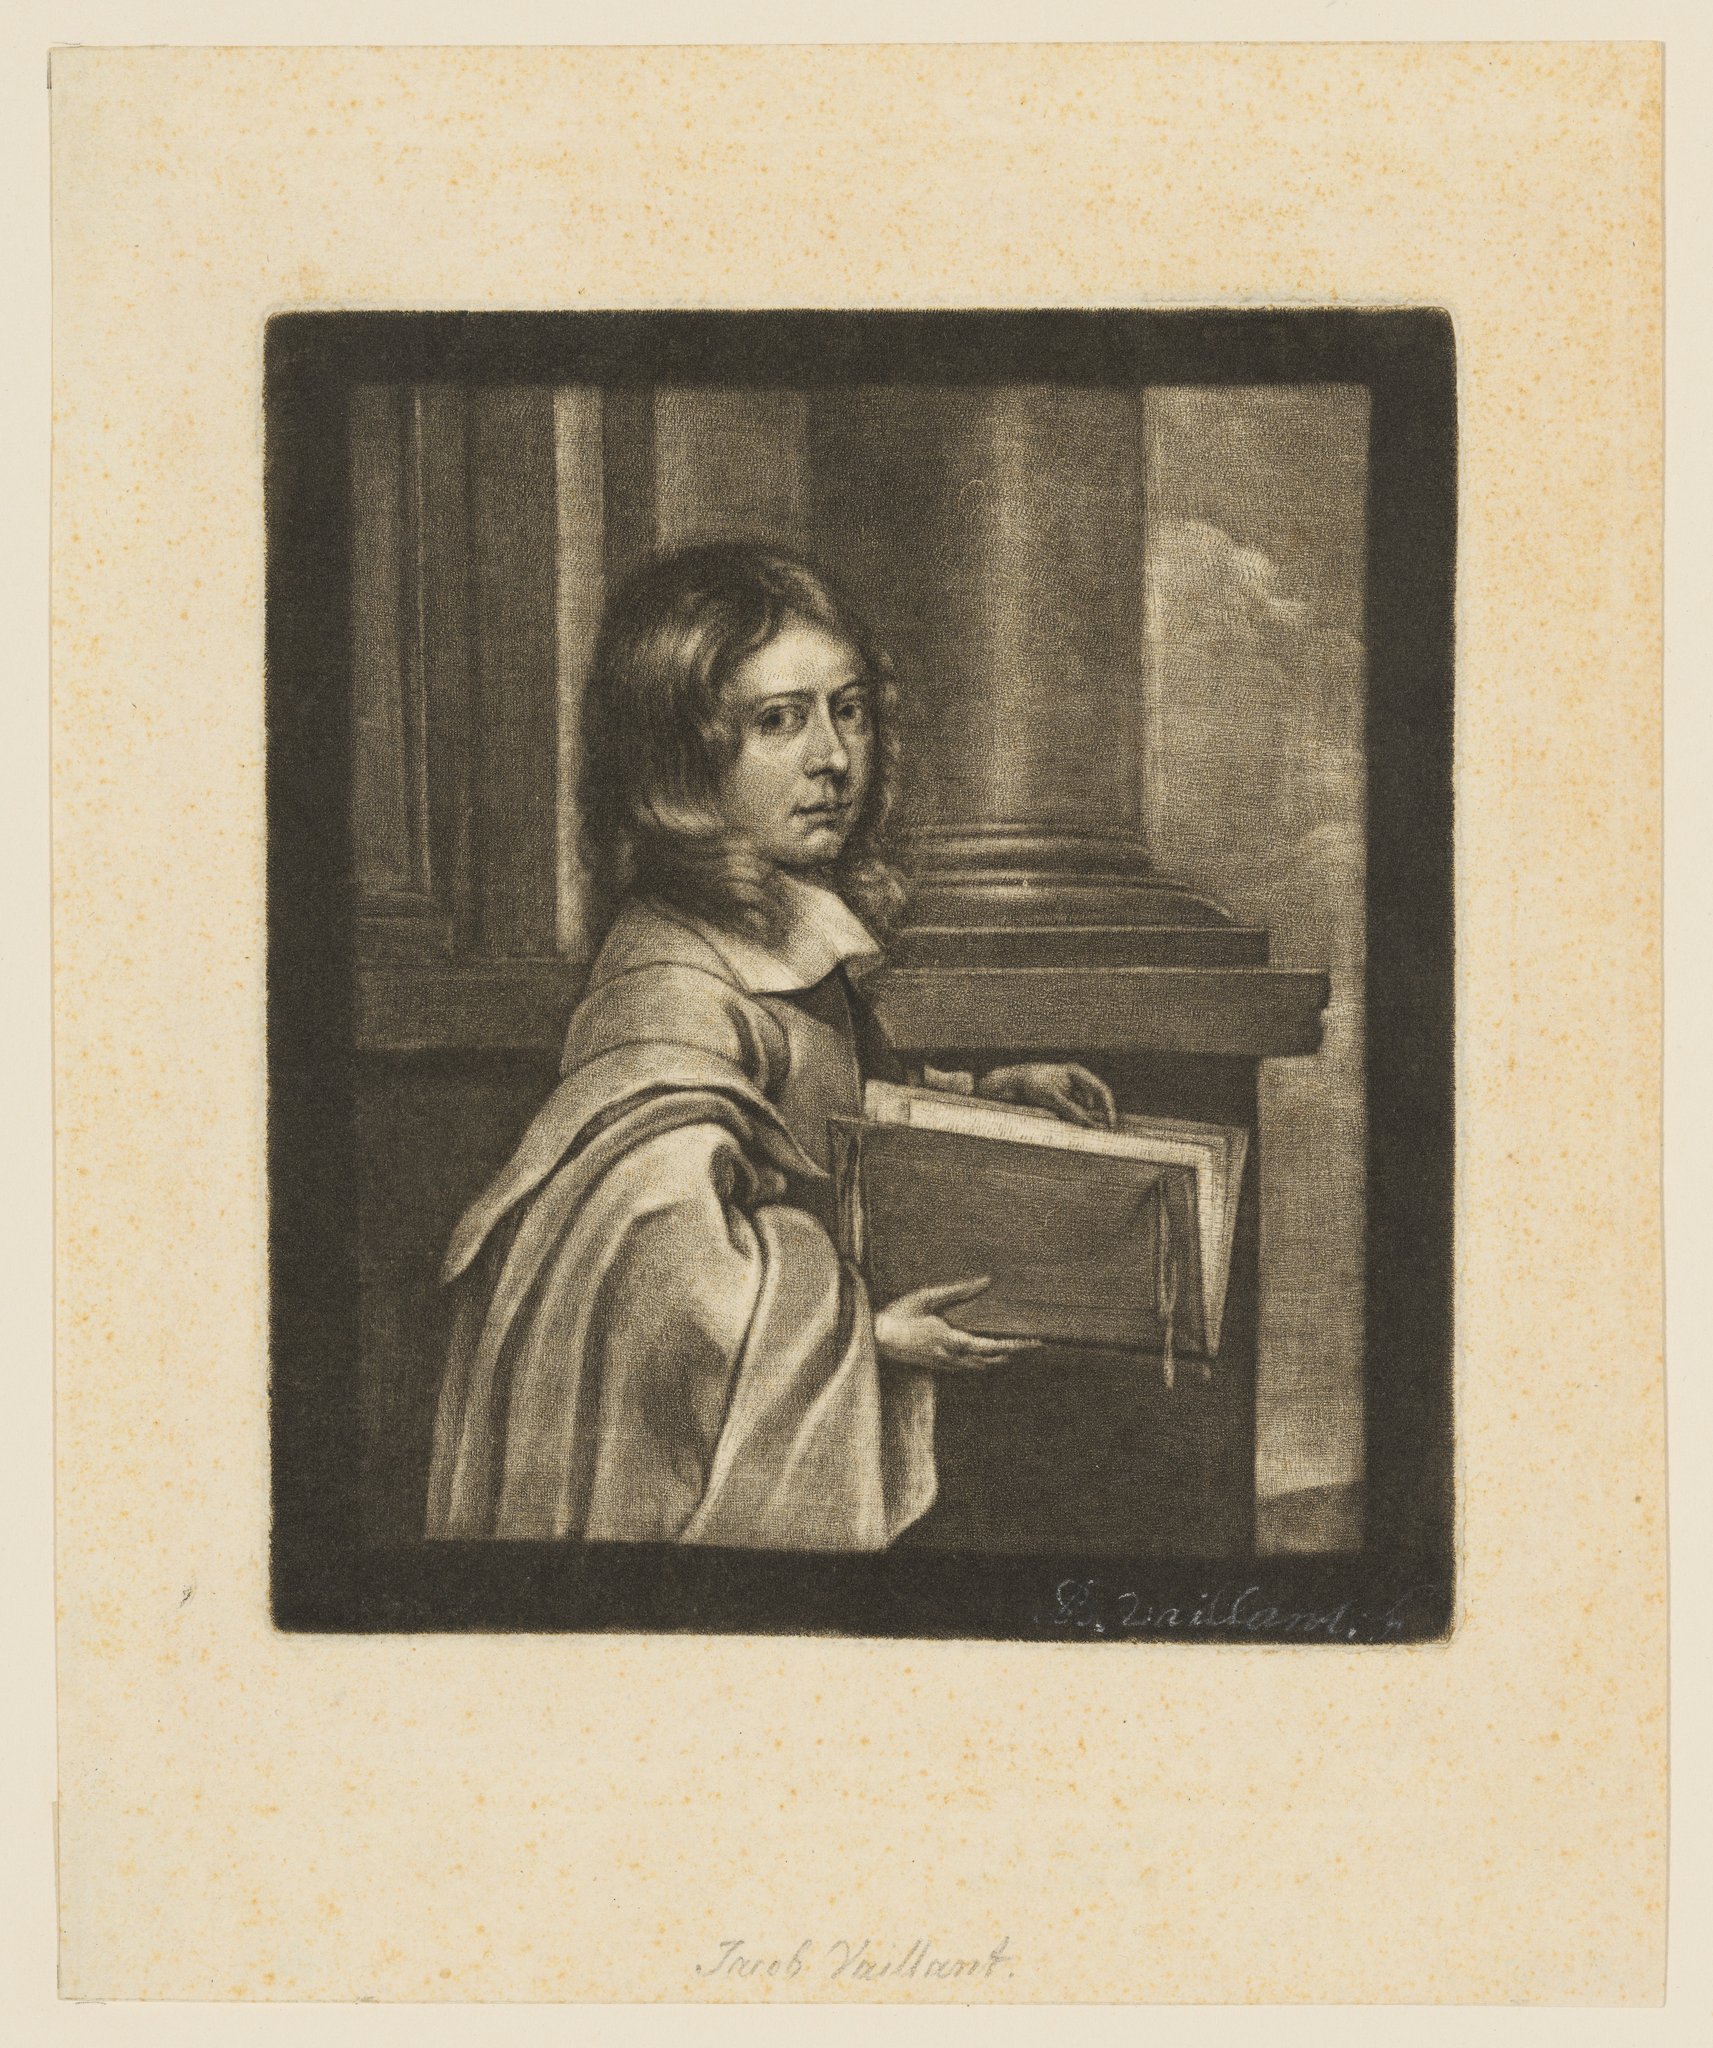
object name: print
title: Standing Boy with a Portfolio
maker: wallerant vaillant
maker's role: artist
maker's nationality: dutch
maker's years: 1623-1677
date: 1634-1666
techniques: mezzotint